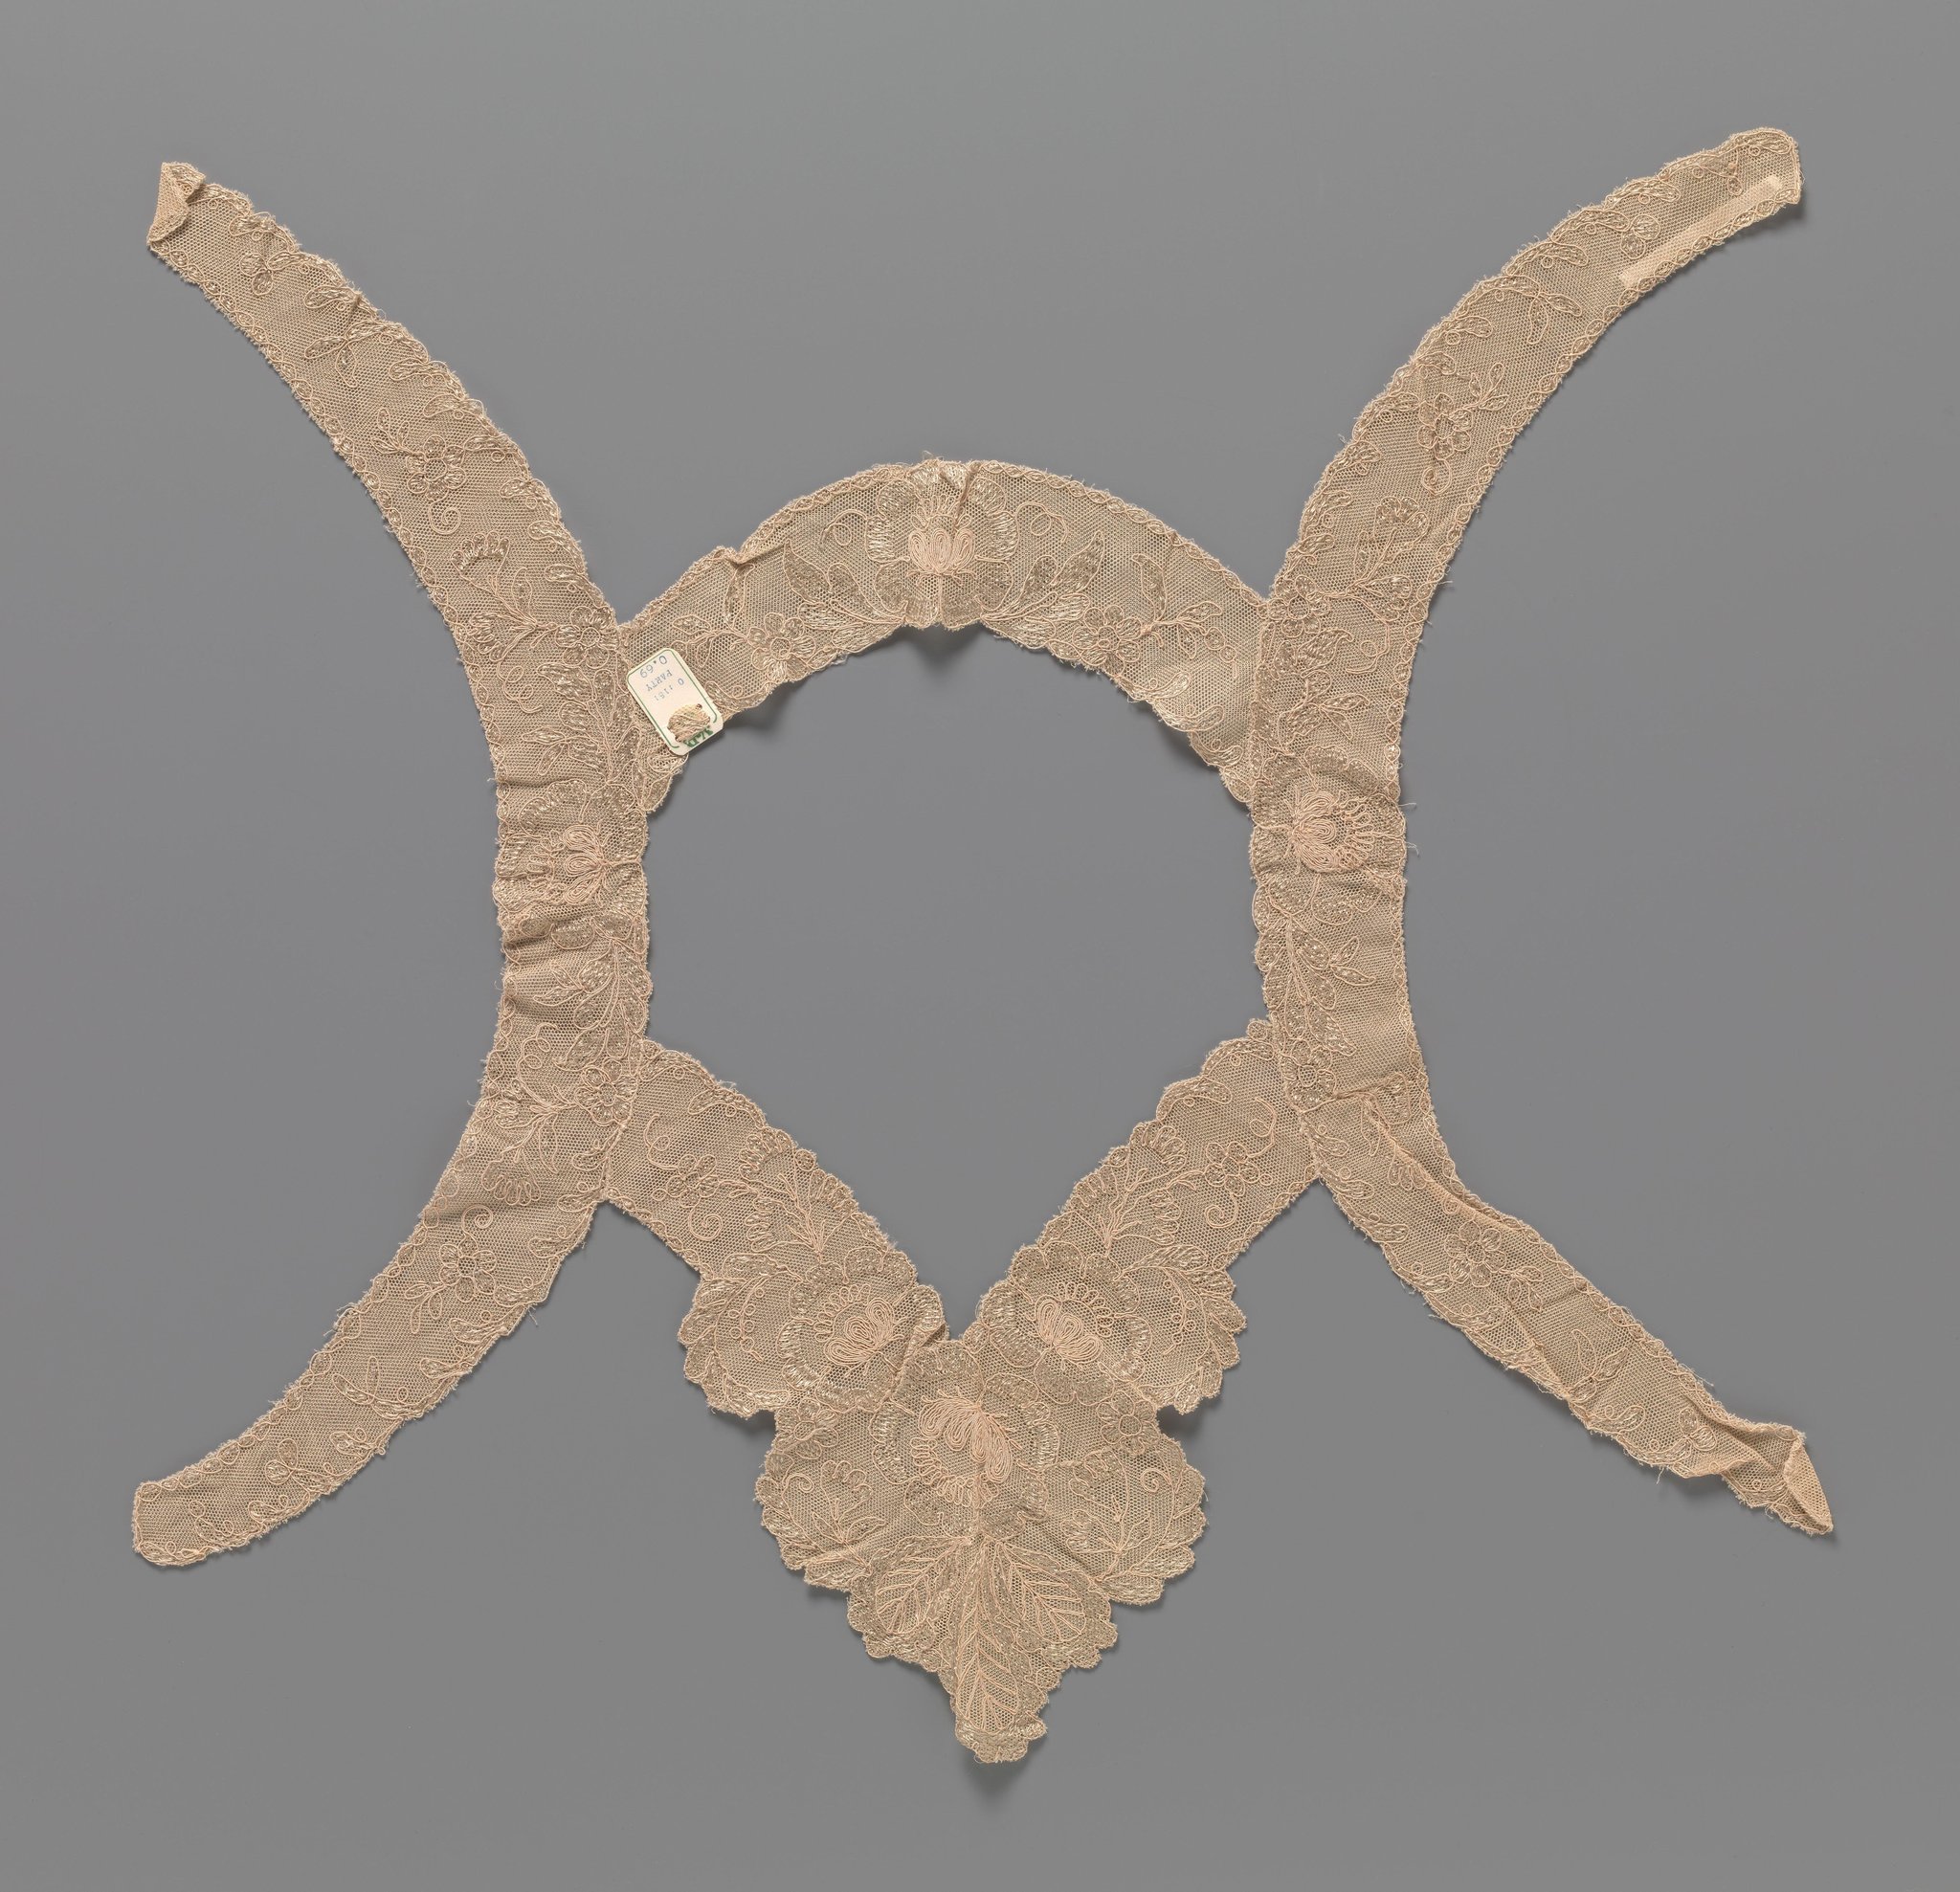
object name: strip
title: Jabot van gemengde kant met overwegend symmetrisch patroon met een slinger van margrieten waar straalsgewijs lange bladtakken onder hangen en onderaan vijf medaillons en twee grote bladeren tussen drie grote margrieten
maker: Anonymous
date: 1880-1890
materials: cotton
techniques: lace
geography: brussels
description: Jabot van naturelkleurige gemengde kant - kloskant in combinatie met een zeer beperkt aantal naaldkantsiersteken - Brusselse duchesse. Ovaalvormig met onderaan een vijfhoekig deel. Overwegend symmetrisch patroon met een hoefijzervormige slinger van margrieten waar straalsgewijs lange bladtakken onder hangen gevolgd door enkele c-voluten. In het veld tussen de slinger met margrieten staat een a-symmetrische bloemtak met trosbloemen van rozetbloempjes en madeliefjes en grote ingesneden bladeren. In het vijfhoekige deel onderaan staat een bloemtak met drie rozetbloemen en daaronder een rij van vijf medaillons. De schulpen daaronder worden gevormd door de twee bladeren tussen de drie grote margrieten. De schulpenrand met fijne schulpjes langs de bovenzijde en twee lange zijden worden gevormd door aaneengeschakelde madeliefjes. Met uitzondering van de vulling in de medaillons die zijn geklost in netslag zijn alle motieven geklost in linnenslag met opengewerkt randjes en enige uitsparingen. De motieven worden geaccentueerd door contourdraden en deels door gekloste reliëfcontouren. In bloemharten zijn enkele naaldkantsiersteken toegepast, waaronder gefestonneerder ringetjes margrieten. De motieven zijn met elkaar verbonden door een vlechtengrond met picots.